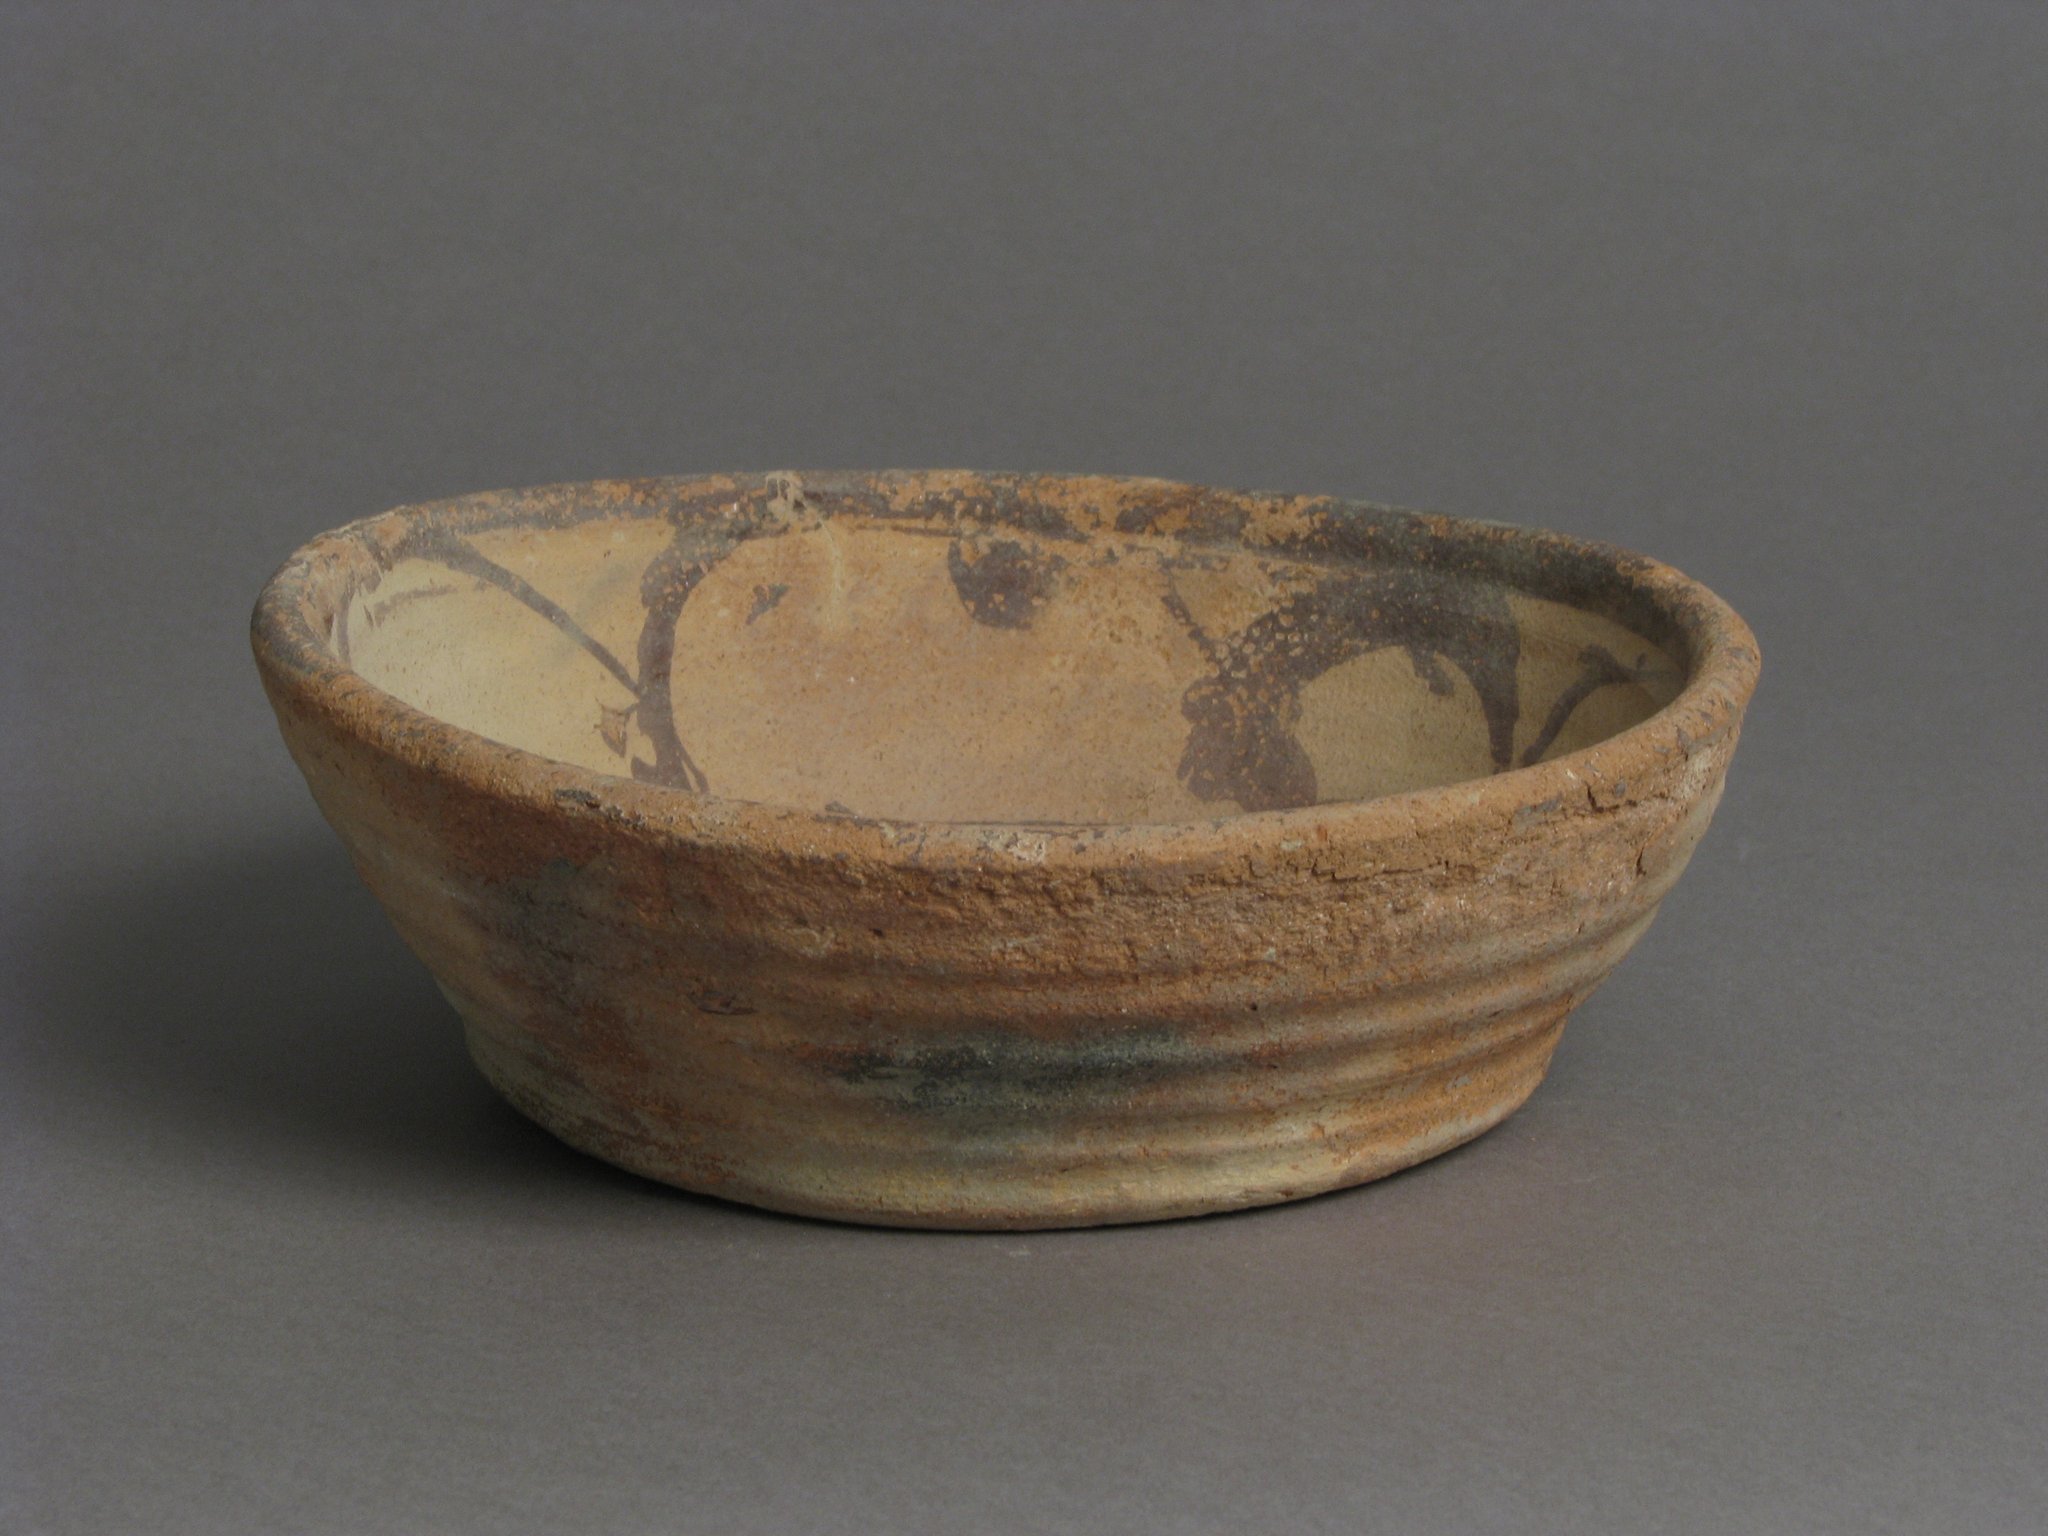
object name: bowl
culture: coptic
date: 301-700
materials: earthenware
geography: egypt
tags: bowls